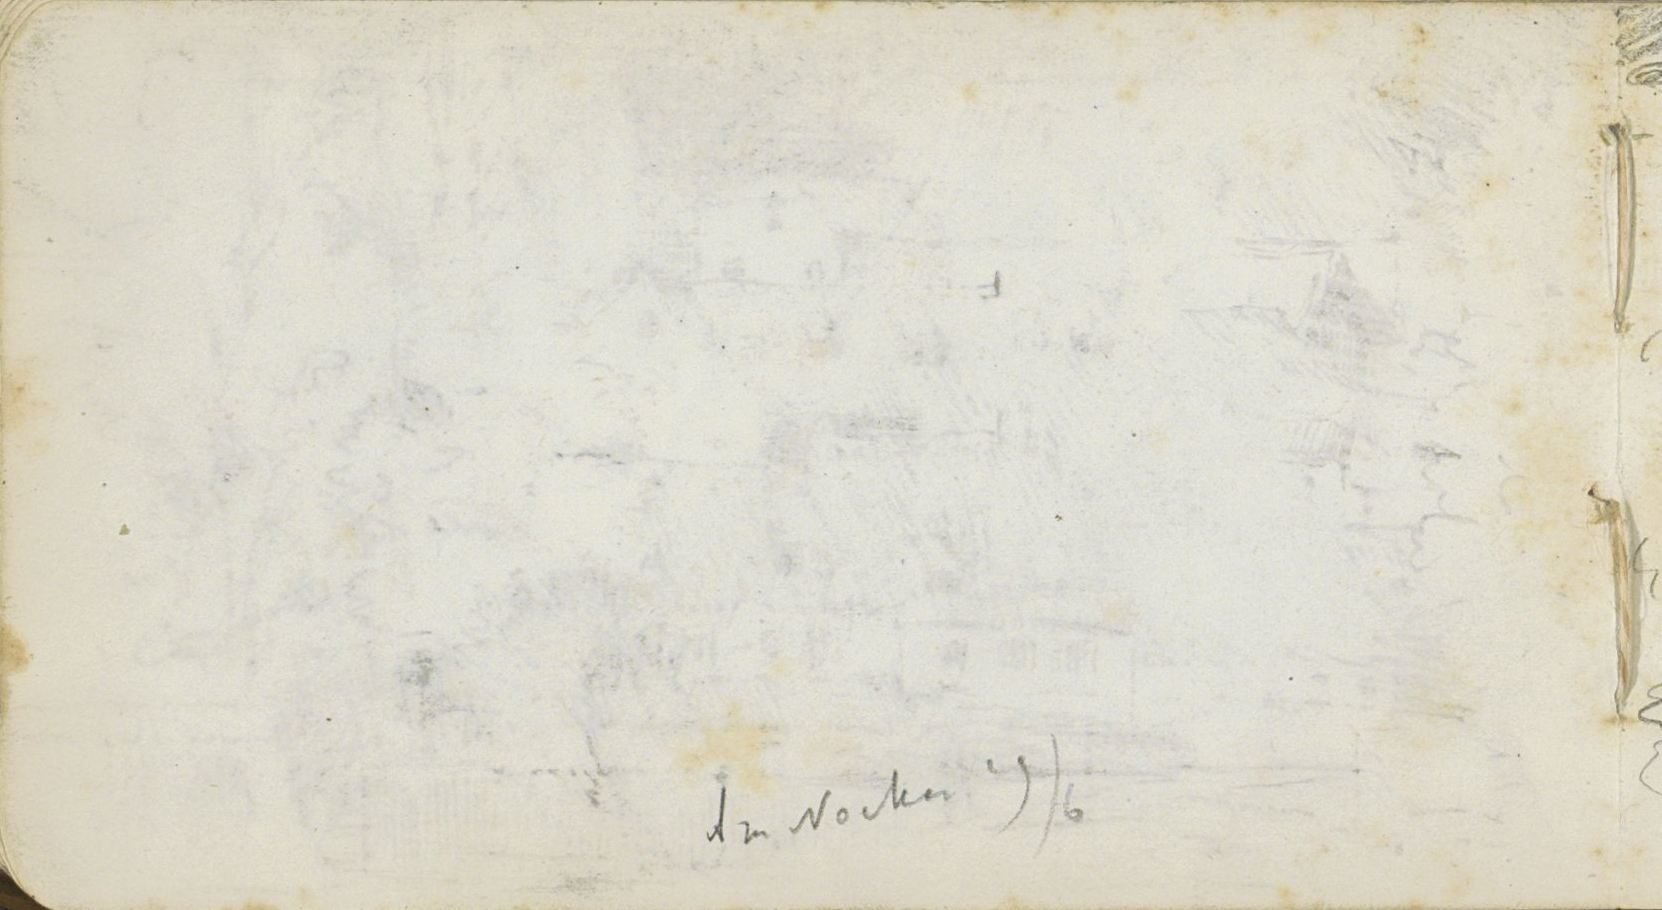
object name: sketchbook leaf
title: Notitie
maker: geo poggenbeek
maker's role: draughtsman, painter, print maker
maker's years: 1853-1903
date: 1806-1876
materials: paper, pencil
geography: heidelberg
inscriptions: date and inscription: ‘Am Nocker [sic]/ 29/6’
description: Blad 4 verso uit een schetsboek met 69 bladen.